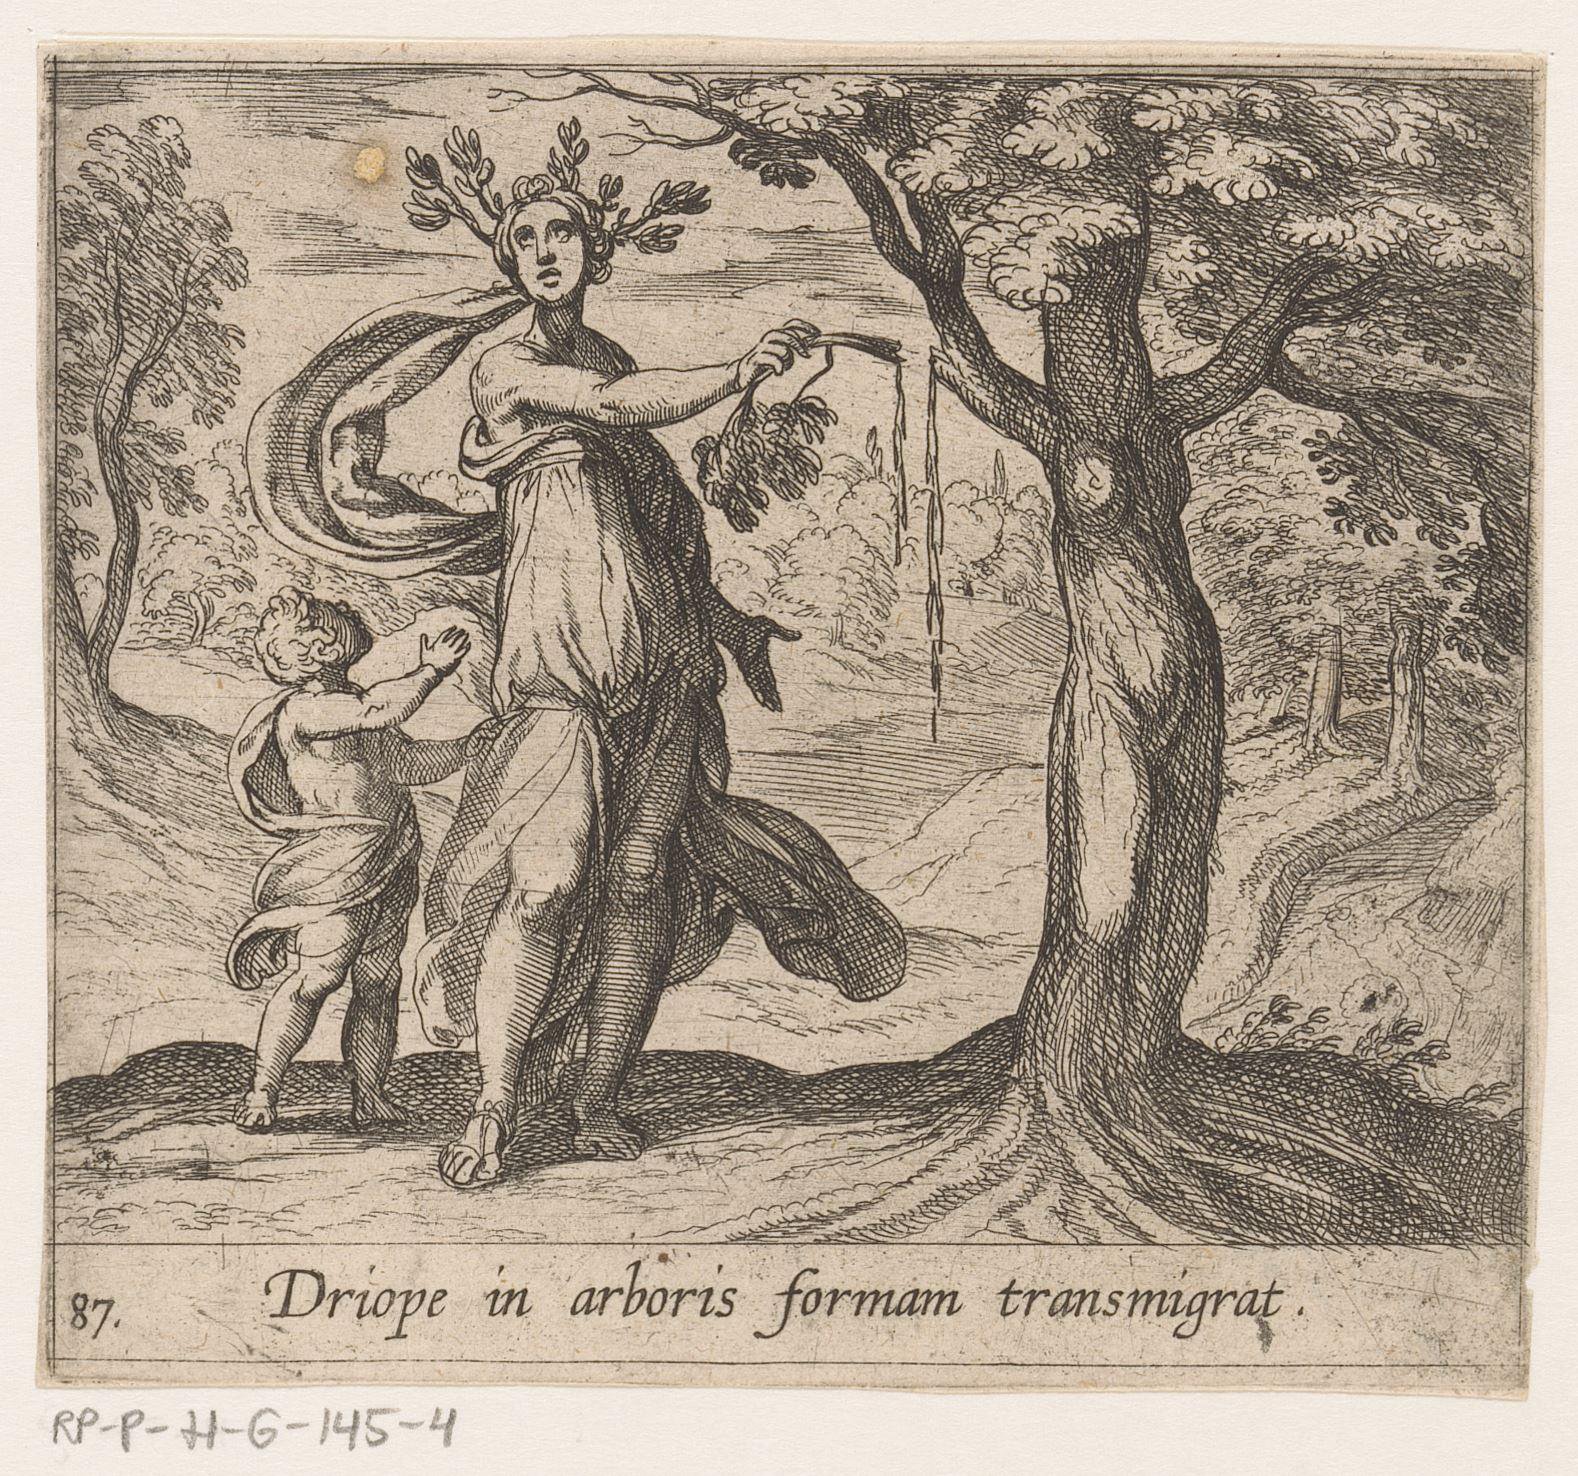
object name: print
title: Metamorfosen van Ovidius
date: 1606-1638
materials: paper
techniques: etching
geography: amsterdam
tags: dryope changed into a lotus-plant: dryope is changed into a lotus-plant, when to please her little boy she picks a flower from a lotus-plant (i.e. lotis metamorphosed) which then starts to bleed (ovid, metamorphoses ix 331)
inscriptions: collector's mark: ‘Hinloopen’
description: Deze prent maakt deel uit van een reeks van 150 prenten (+ titelprent) met voorstellingen van de Metamorfosen van Ovidius.